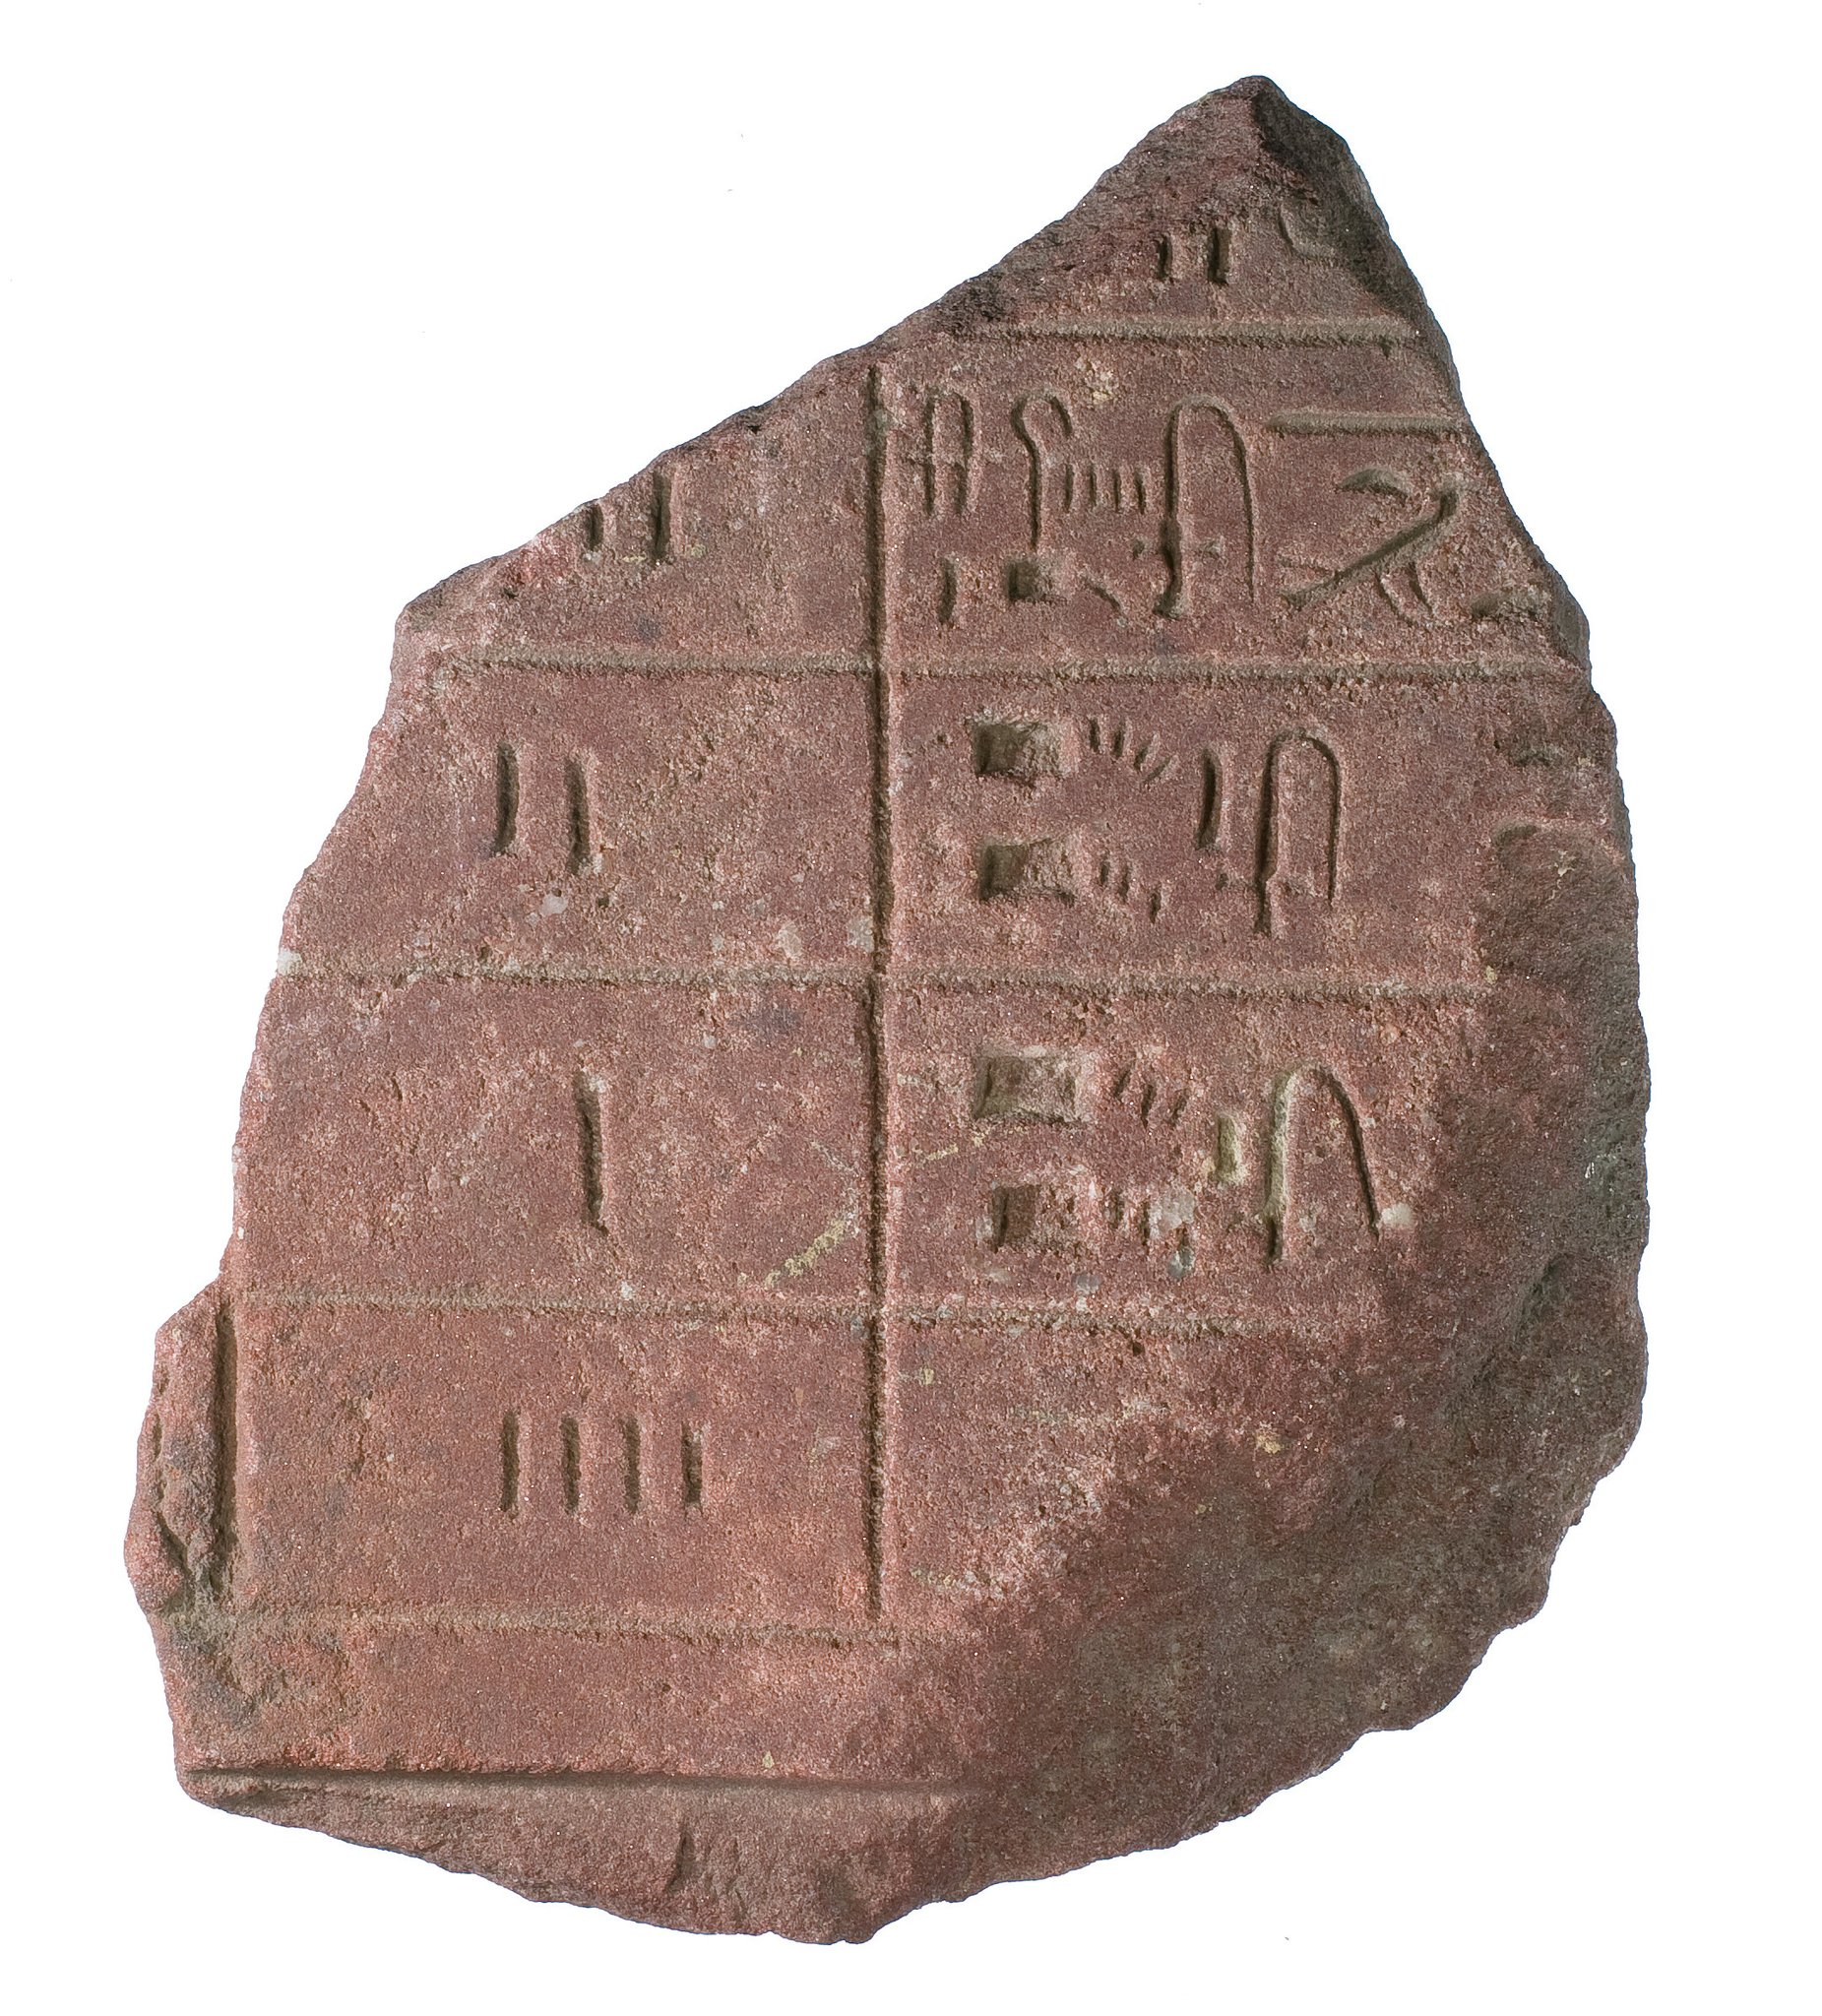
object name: offering list stela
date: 1353-1336 BCE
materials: quartzite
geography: egypt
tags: hieroglyphs